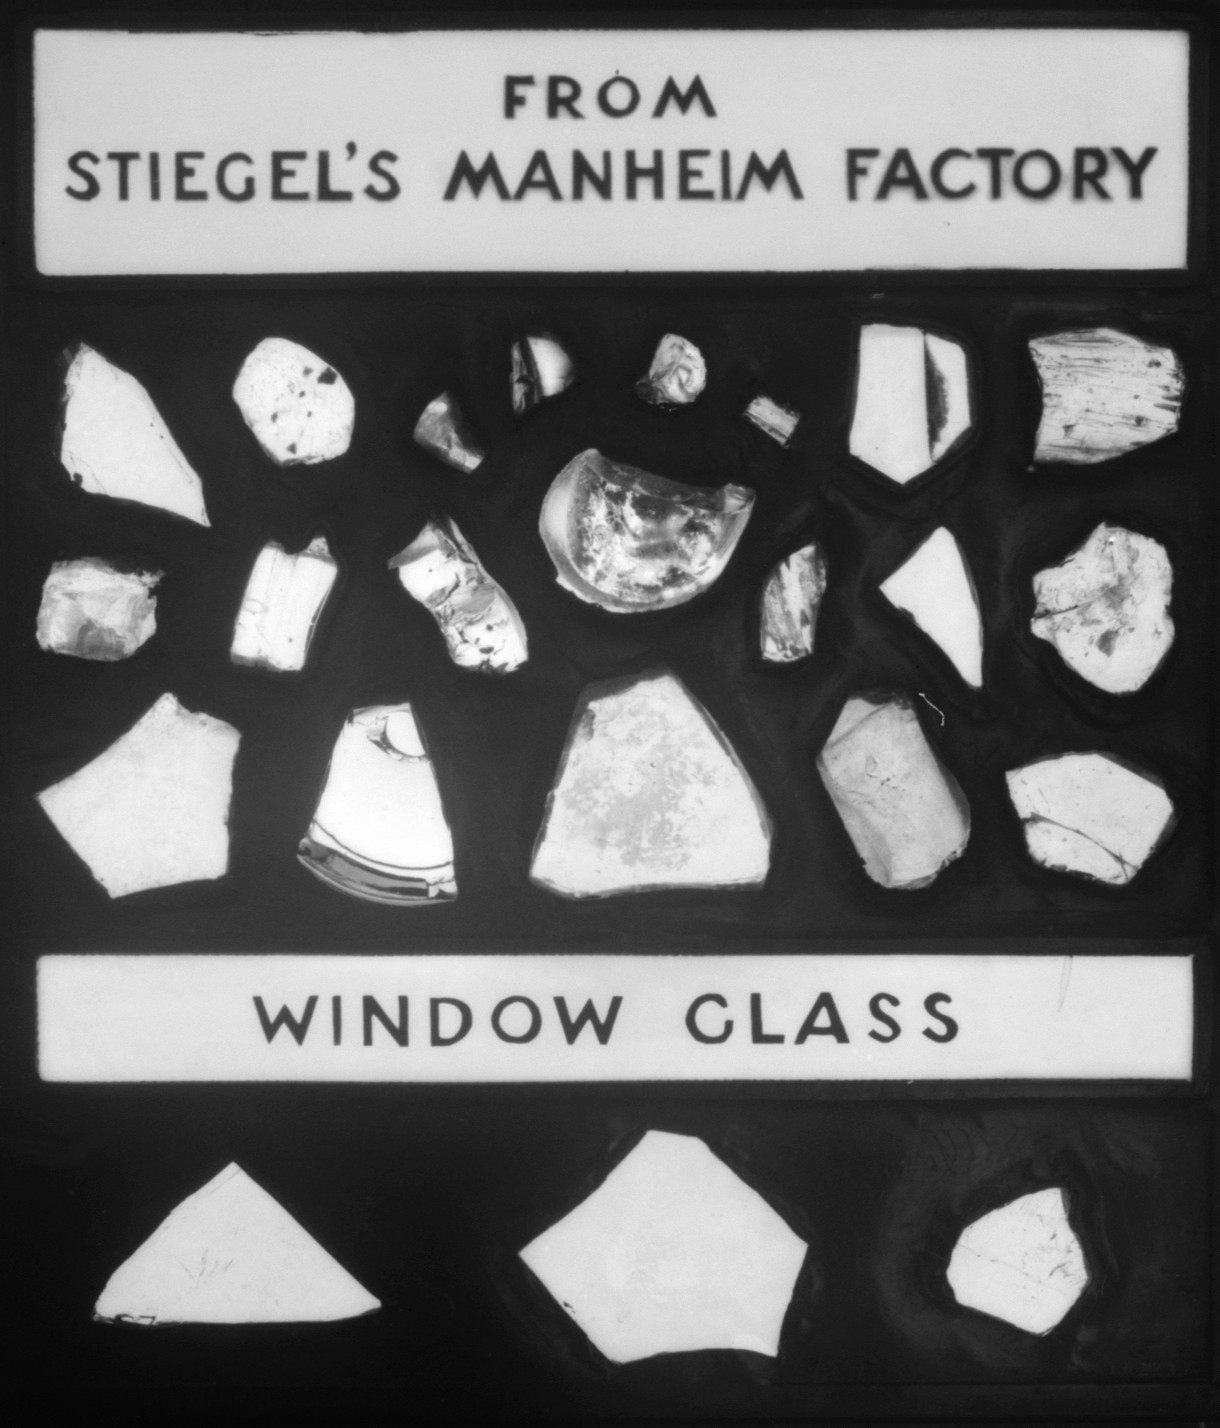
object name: glass panel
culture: american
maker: stiegel's manheim factory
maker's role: maker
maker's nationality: american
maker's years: 1763-1774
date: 1763-1774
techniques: glassblowing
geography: united states